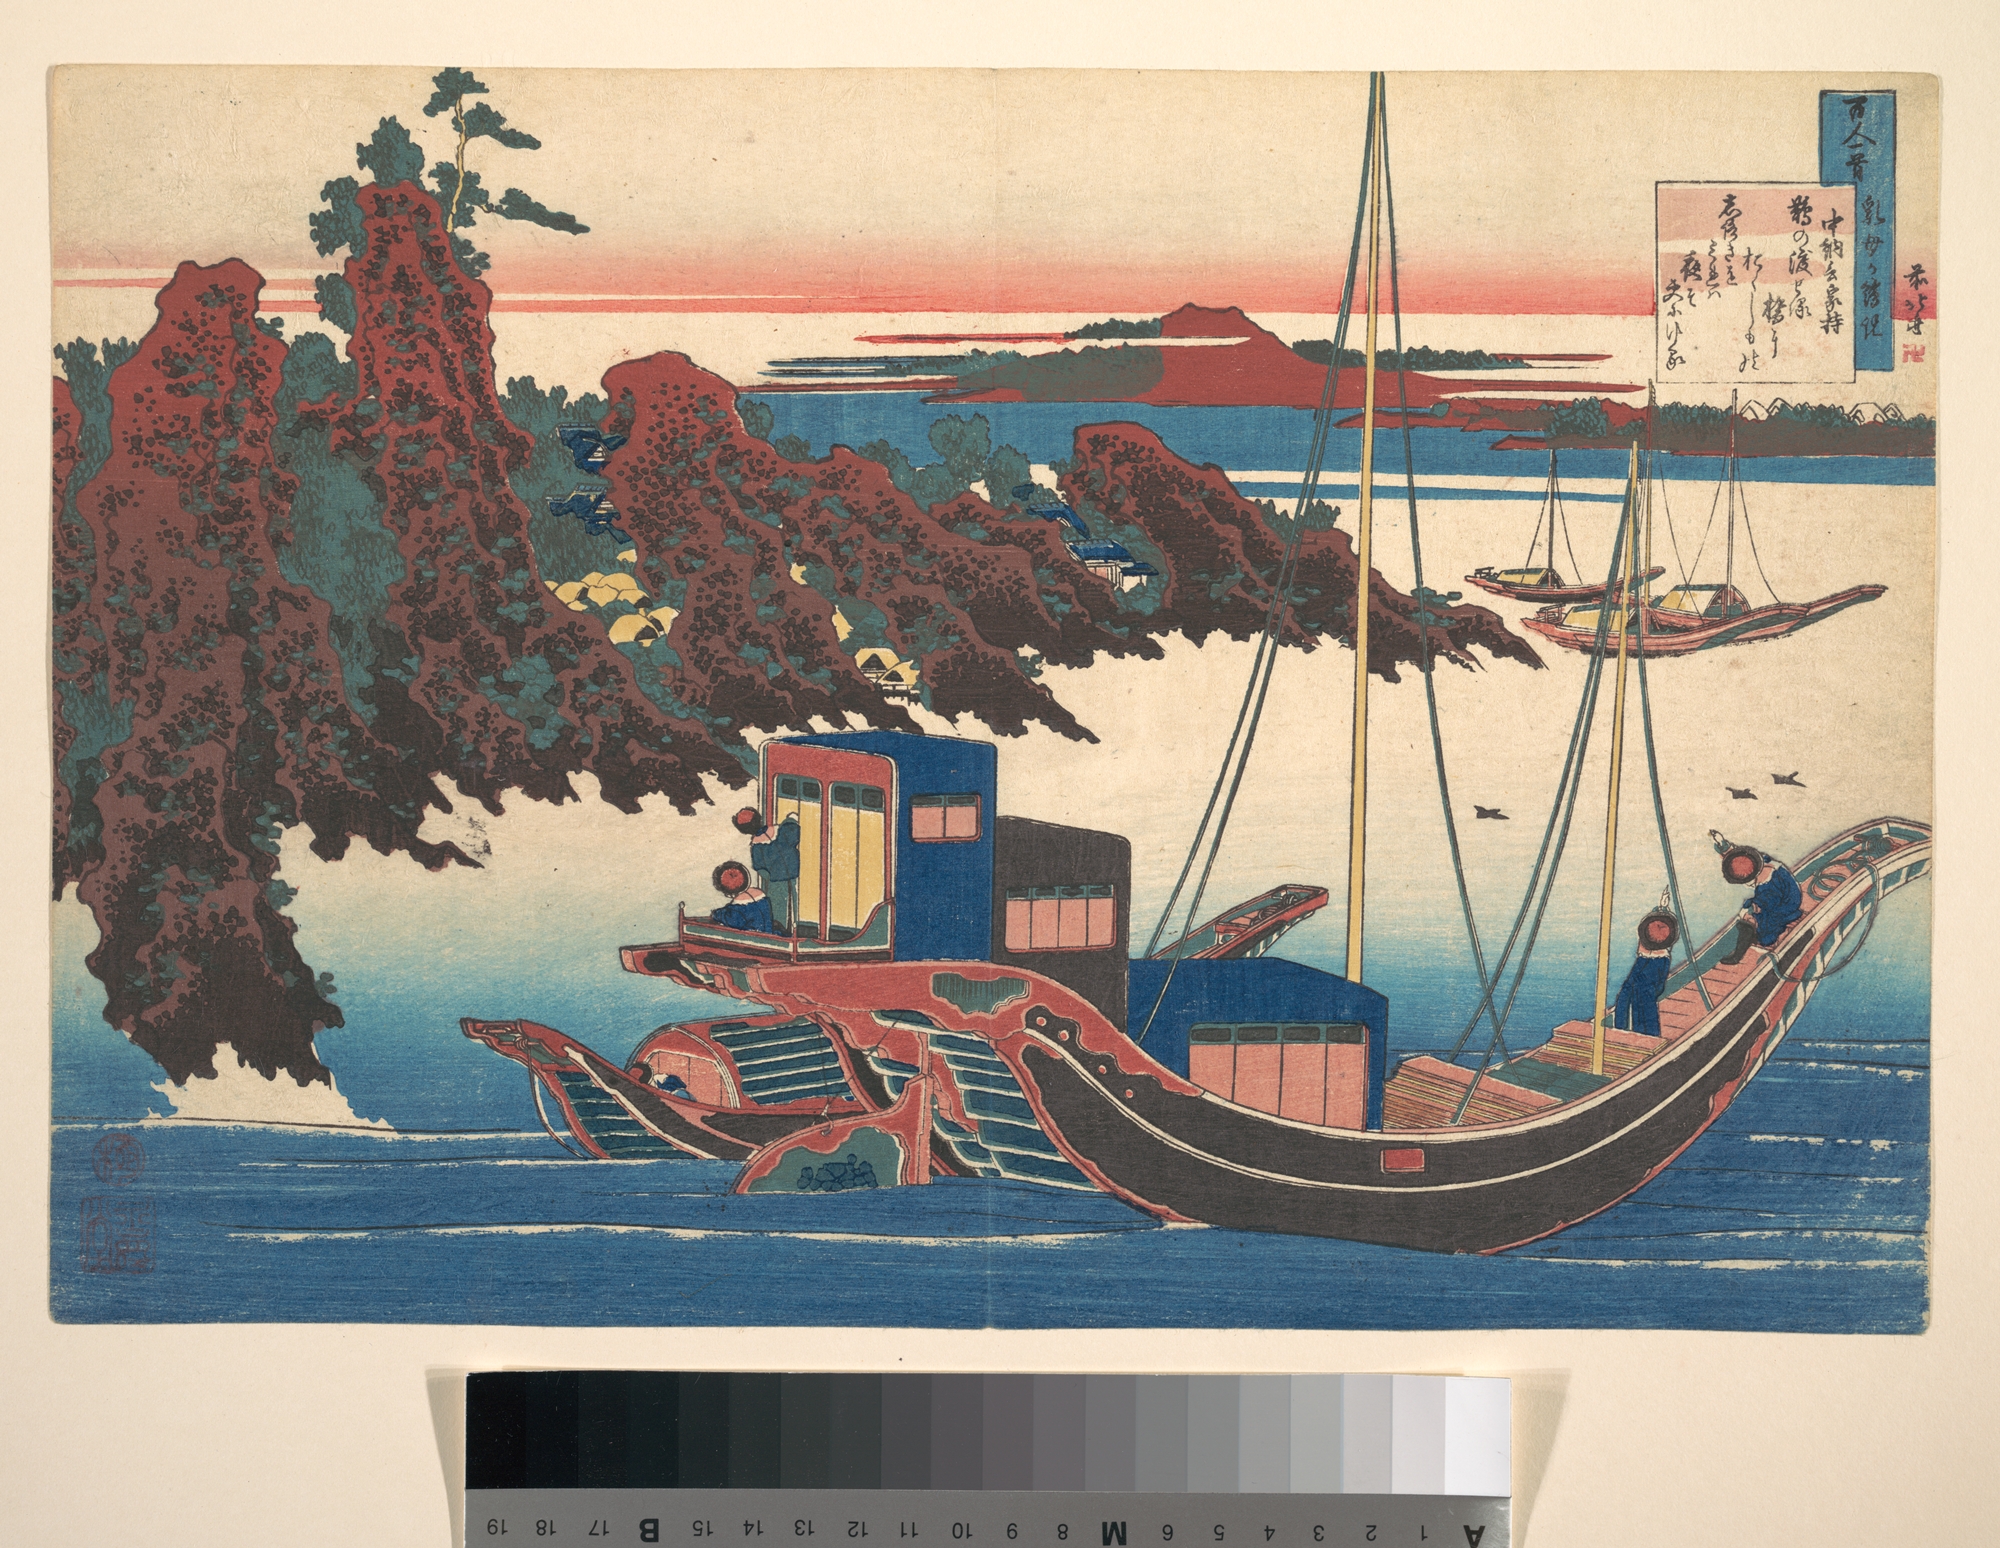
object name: woodblock print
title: Poem by Chūnagon Yakamochi (Ōtomo no Yakamochi), from the series One Hundred Poems Explained by the Nurse (Hyakunin isshu uba ga etoki)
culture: japanese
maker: katsushika hokusai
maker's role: artist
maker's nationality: japanese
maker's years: 1760-1849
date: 1760-1849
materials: ink, paper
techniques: woodblock print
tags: boats